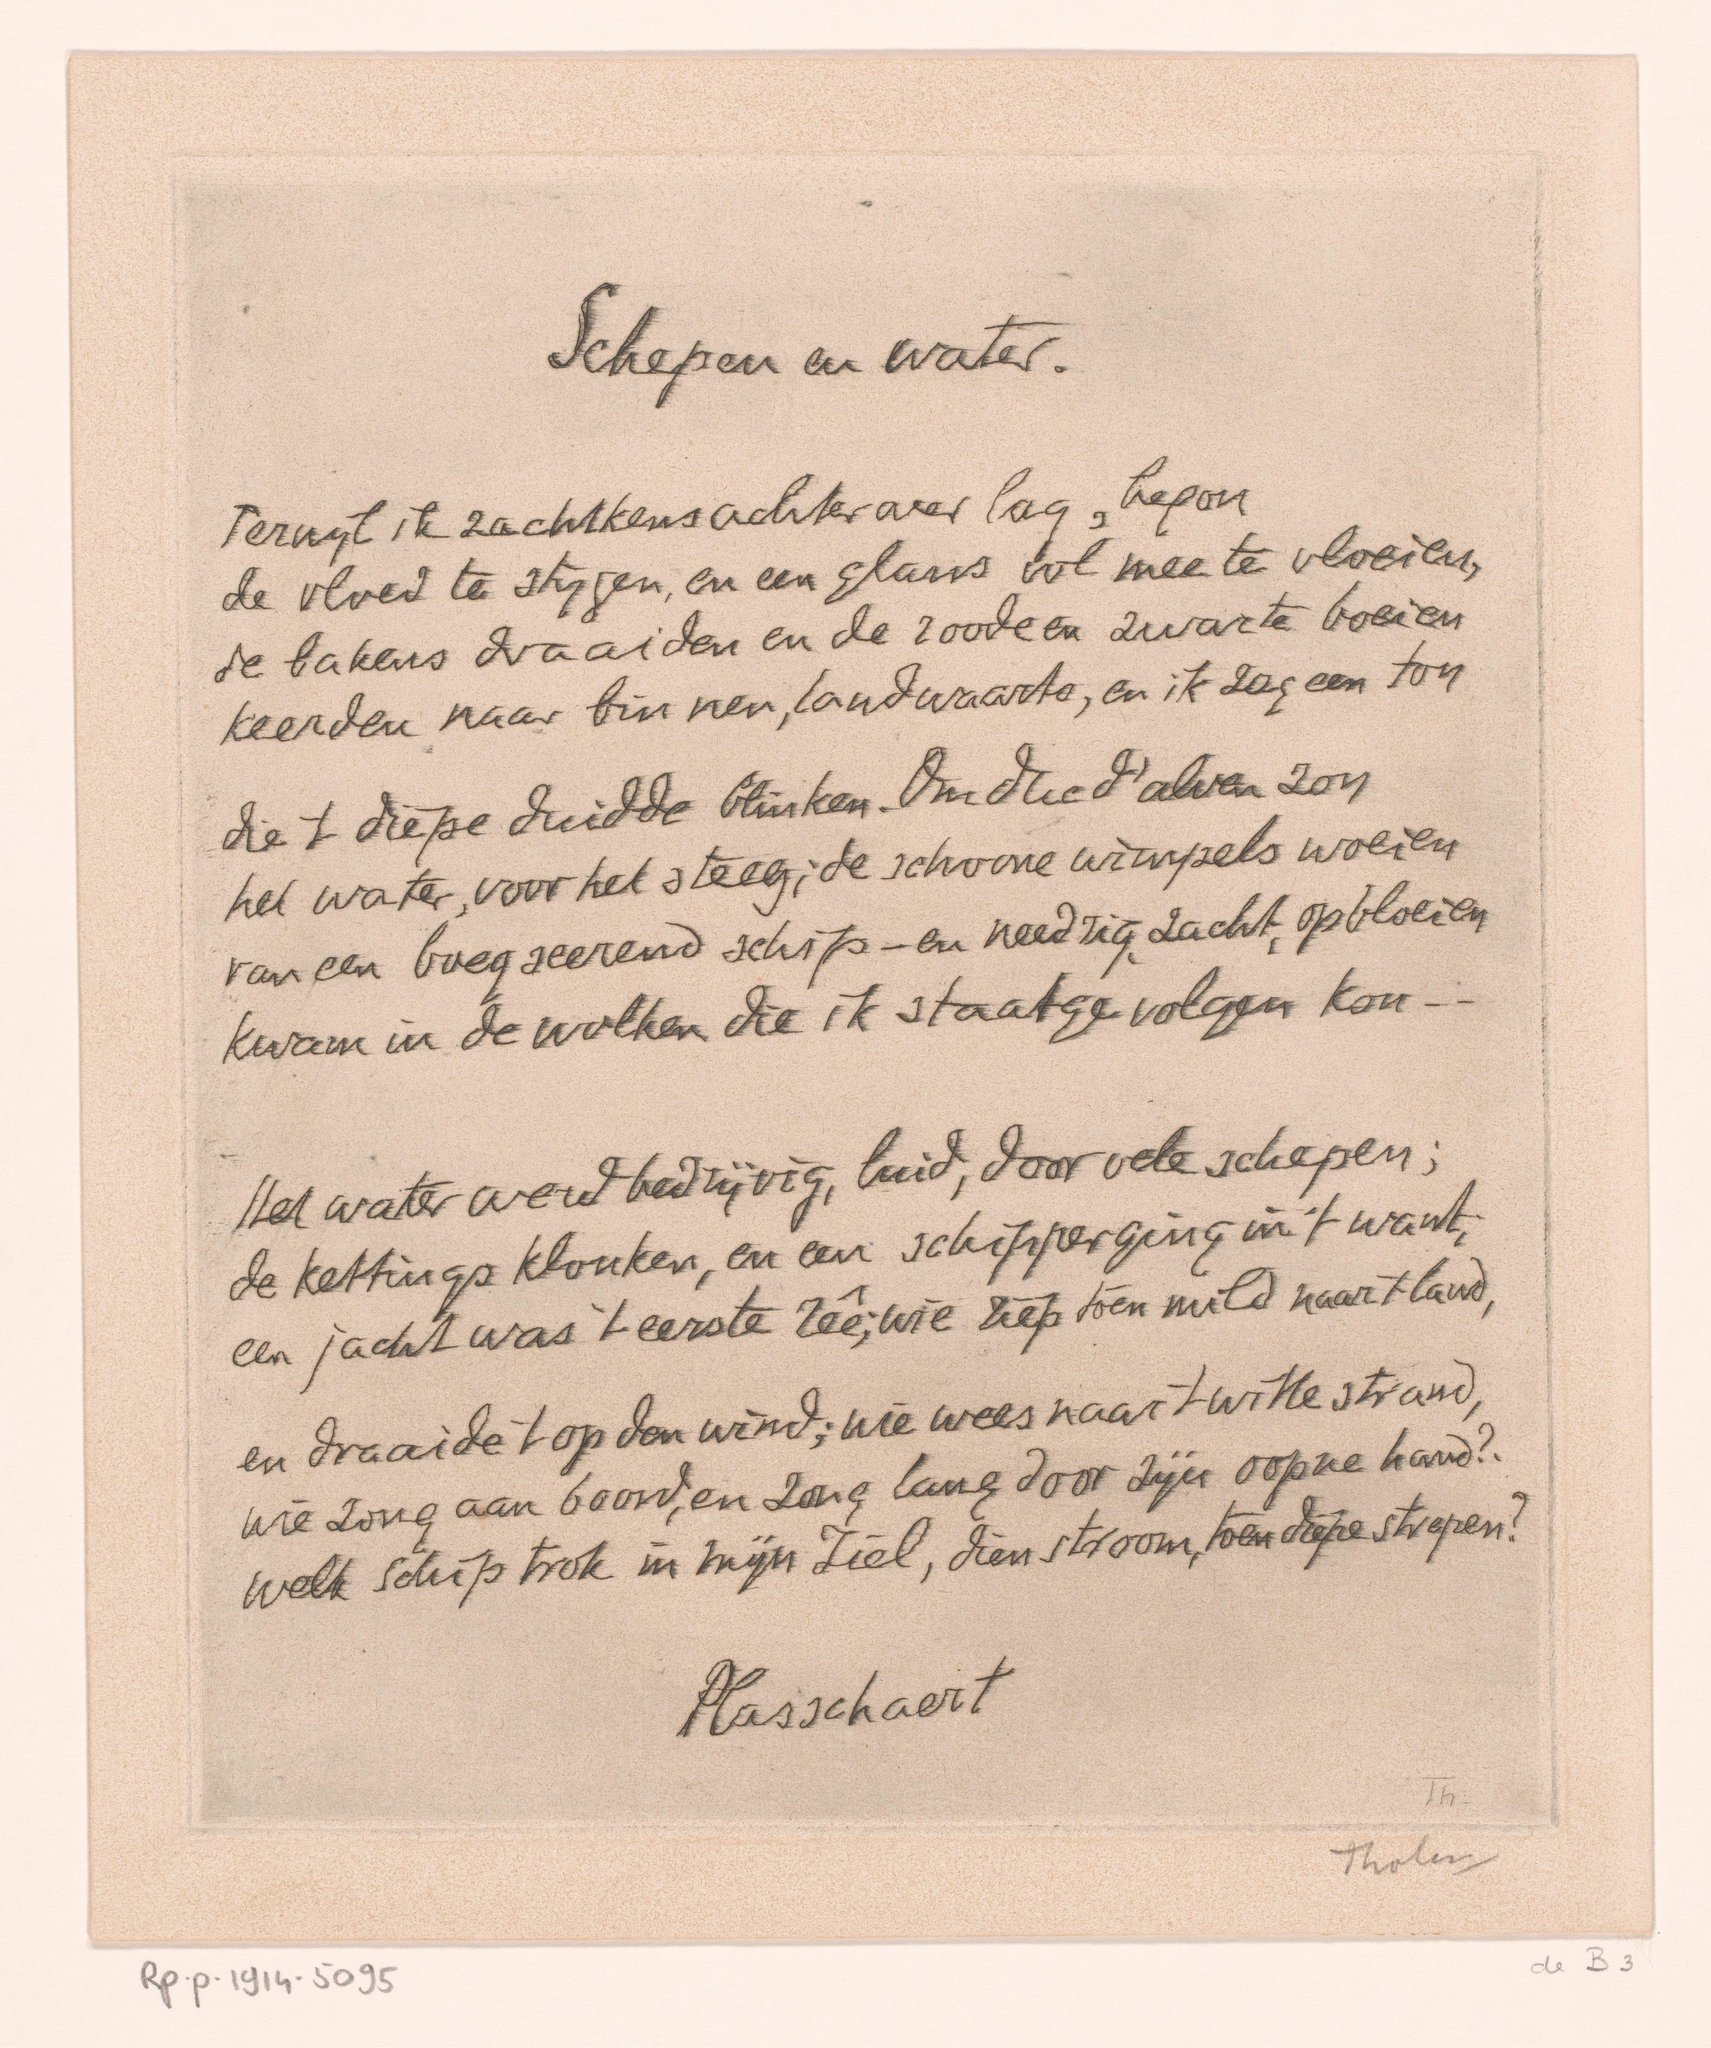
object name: poem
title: Schepen en water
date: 1870-1914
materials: paper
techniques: etching, intaglio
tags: handwriting, written text, author, poet writing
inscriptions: collector's mark: Lugt 2233, poem: ‘Terwijl ik zachtkens achterover lag, begon/ de vloed te stijgen, en ene glans vol mee te vloeien (...)’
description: Het gedicht 'Schepen en water' van Albert Charles Auguste Plasschaert.